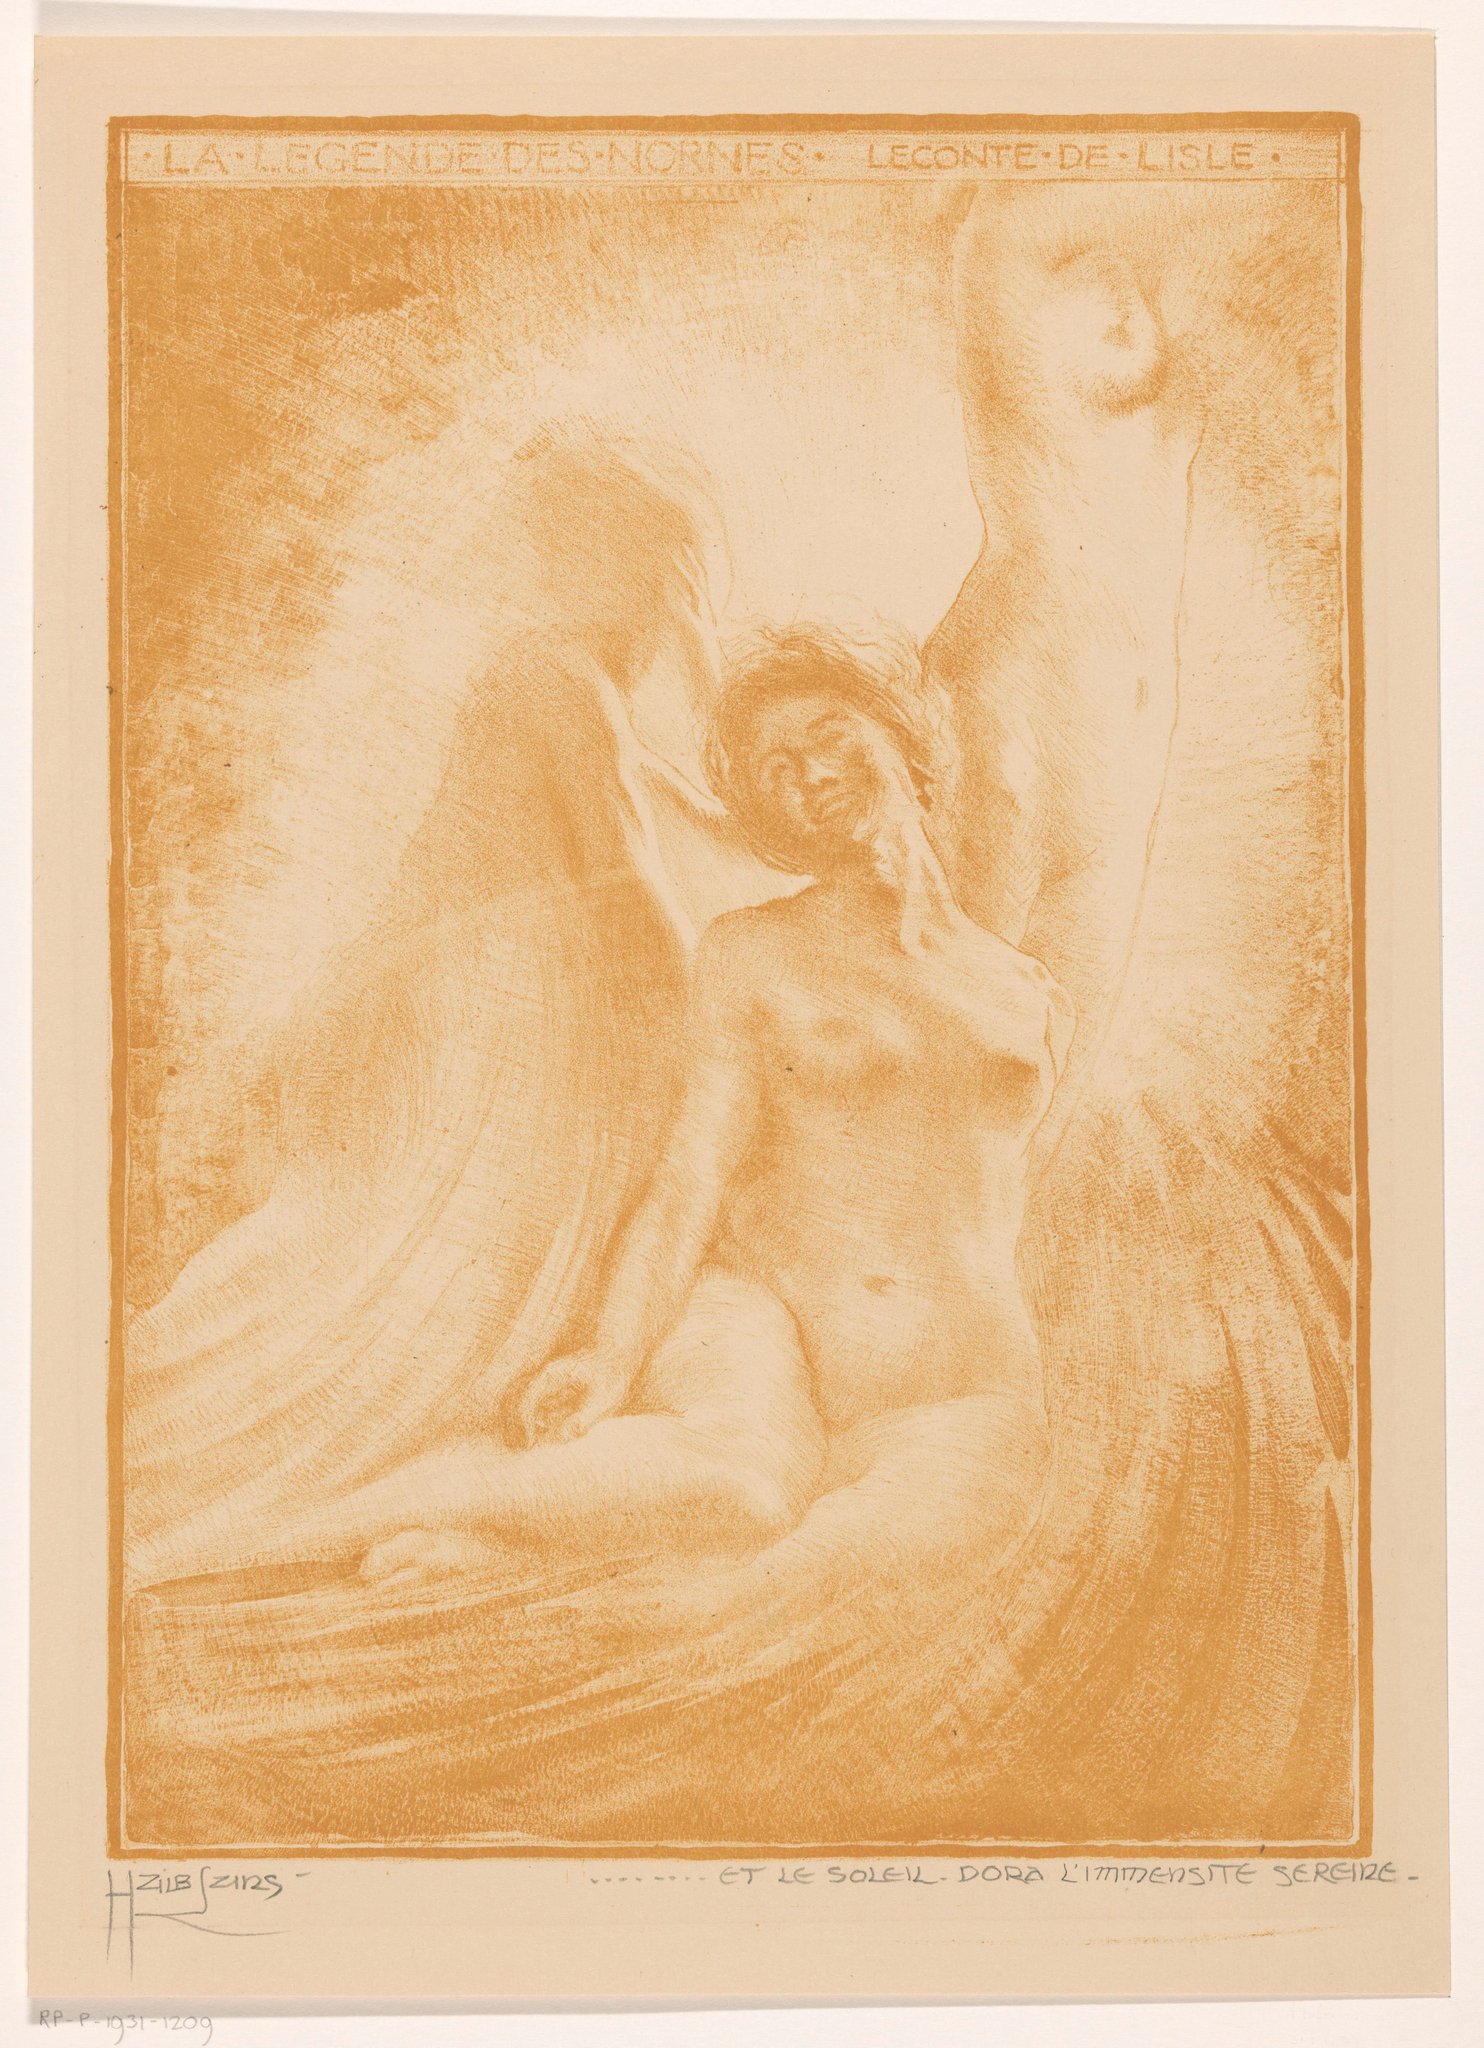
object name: print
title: La legende des nornes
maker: huib luns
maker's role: draughtsman, print maker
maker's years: 1881-1942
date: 1891-1931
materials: paper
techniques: lithograph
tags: fate, doom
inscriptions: caption: ‘........et le soleil dora l'immensité sereine.’, collector's mark: Lugt 2228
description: De prent en het onderschrift verwijzen naar het gedicht 'La legende des nornes' uit: Leconte de Lisle, Charles. Poèmes barbares. 1872.